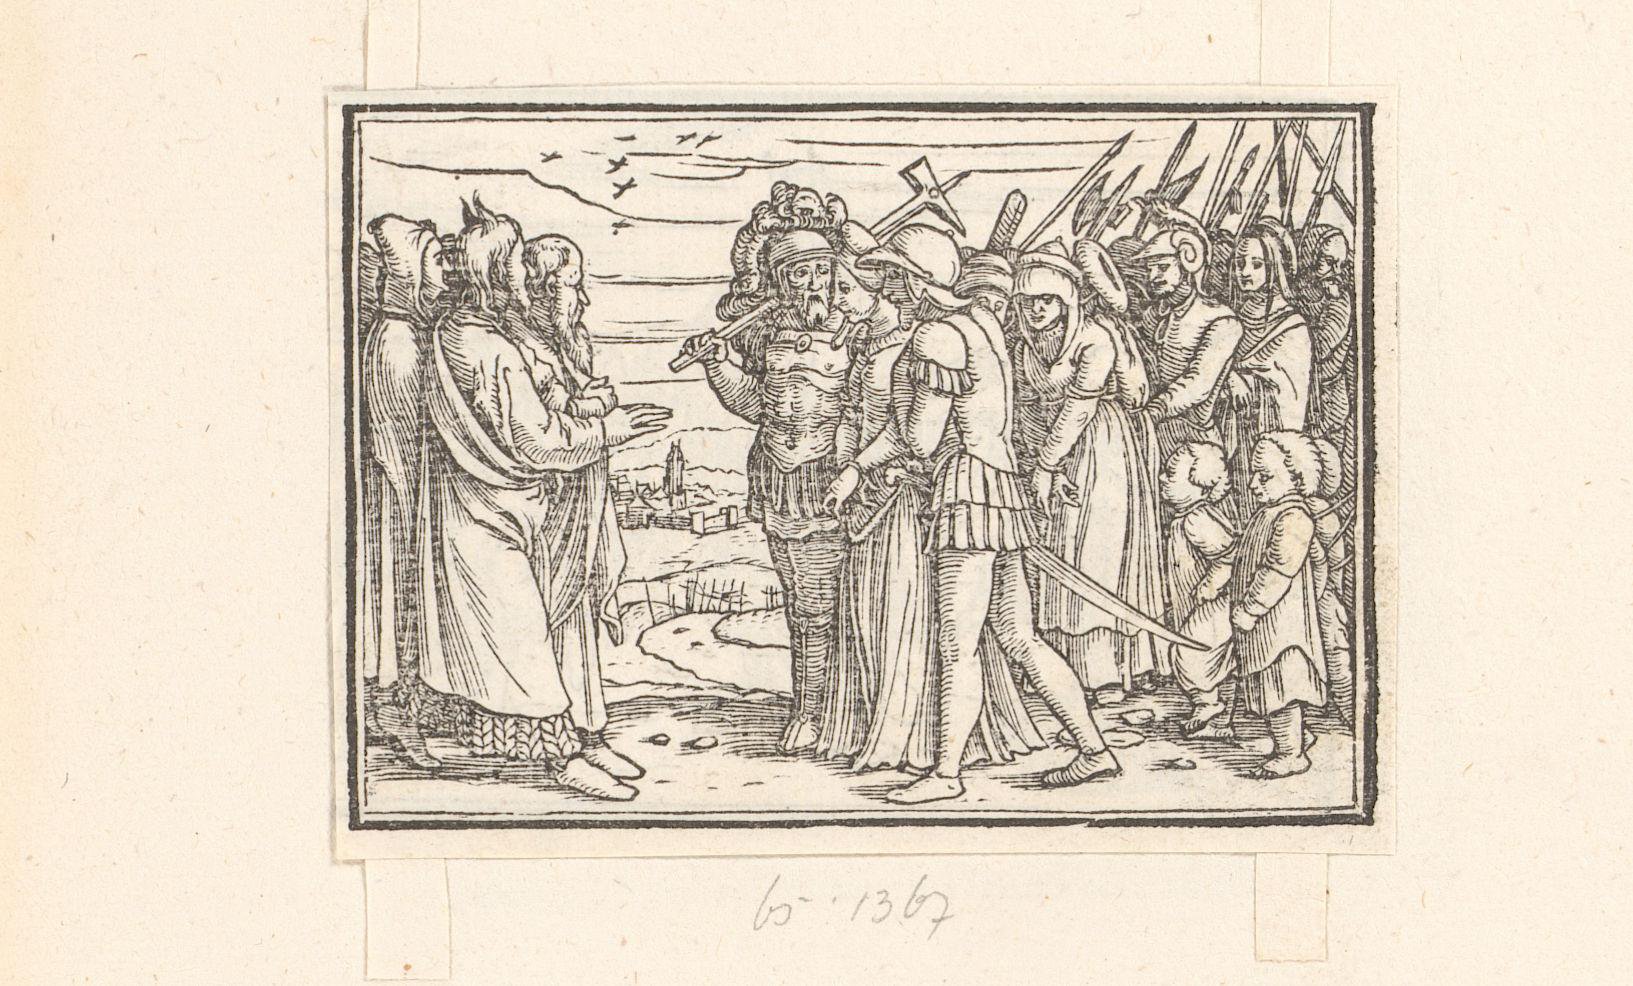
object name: album leaf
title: Geschiedenis van het Oude Testament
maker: veit rudolf specklin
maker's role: print maker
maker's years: -1550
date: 1538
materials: paper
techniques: woodcut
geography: switzerland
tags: moses orders the death of the mature midianite women and their male children after the victory of the israelites over the midianites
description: Boekillustratie voor het eerst gebruikt in: Biblia Utriusque Testamenti iuxta Vulgatam Translationem, Lyon, M. en G. Trechsel (voor Hugo à Porta) 1538. Later in verschillende uitgaven opnieuw gebruikt. Deze prent vermoedelijk gebruikt in één van de uitgaven uitgegeven en/of gedrukt door Jean Frellon, Lyon.